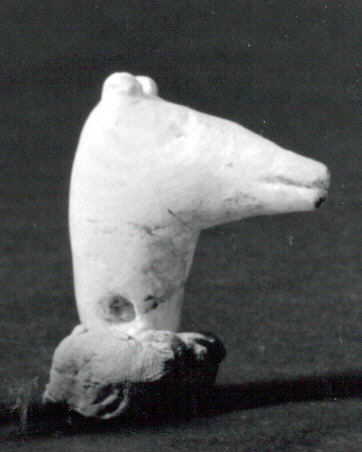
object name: bead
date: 7333-7001 BCE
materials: alabaster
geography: syria